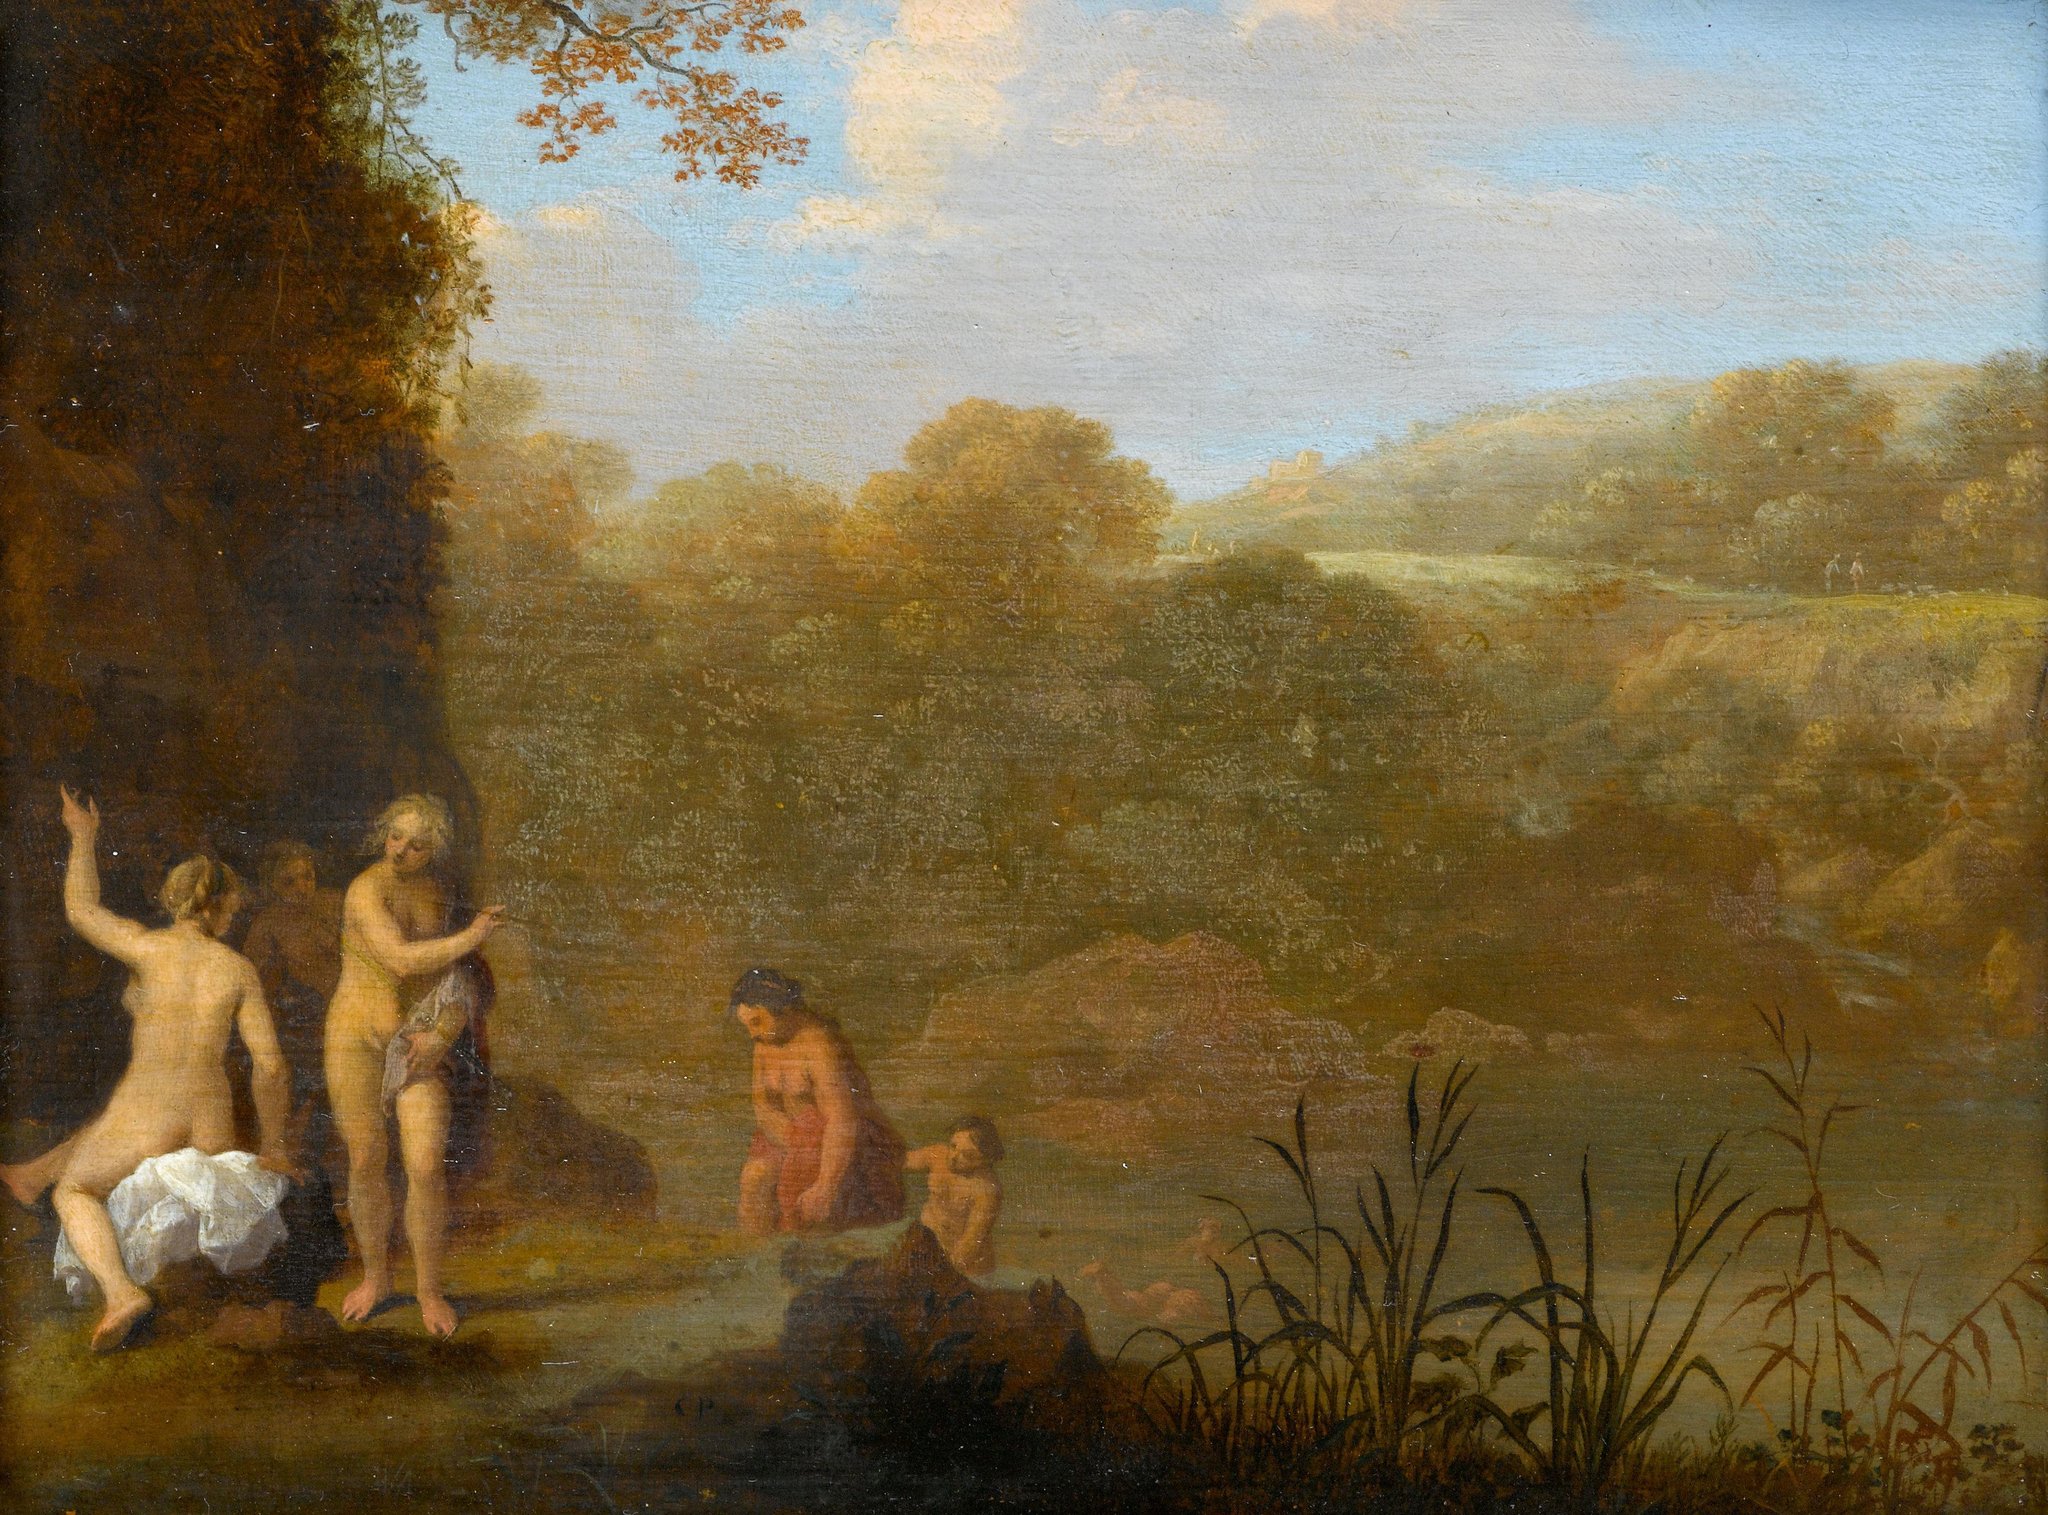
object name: painting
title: Bathing Girls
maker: cornelis van poelenburch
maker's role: draughtsman, painter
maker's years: 1594-1667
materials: oil, panel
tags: taking a bath - aa - in the open air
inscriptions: signature, bottom centre, with monogram: ‘CP’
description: Badende meisjes. Landschap met een groep van vijf badende vrouwen, Drie staan zich te drogen op de oever, twee komen net uit het water. Pendant van SK-A-310.